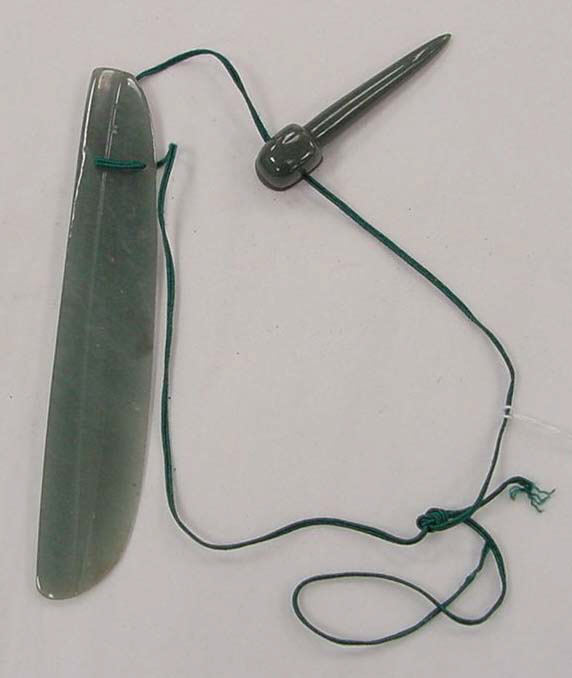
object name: necklace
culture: indigenous american or costa rican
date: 500 BCE-900 CE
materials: jade